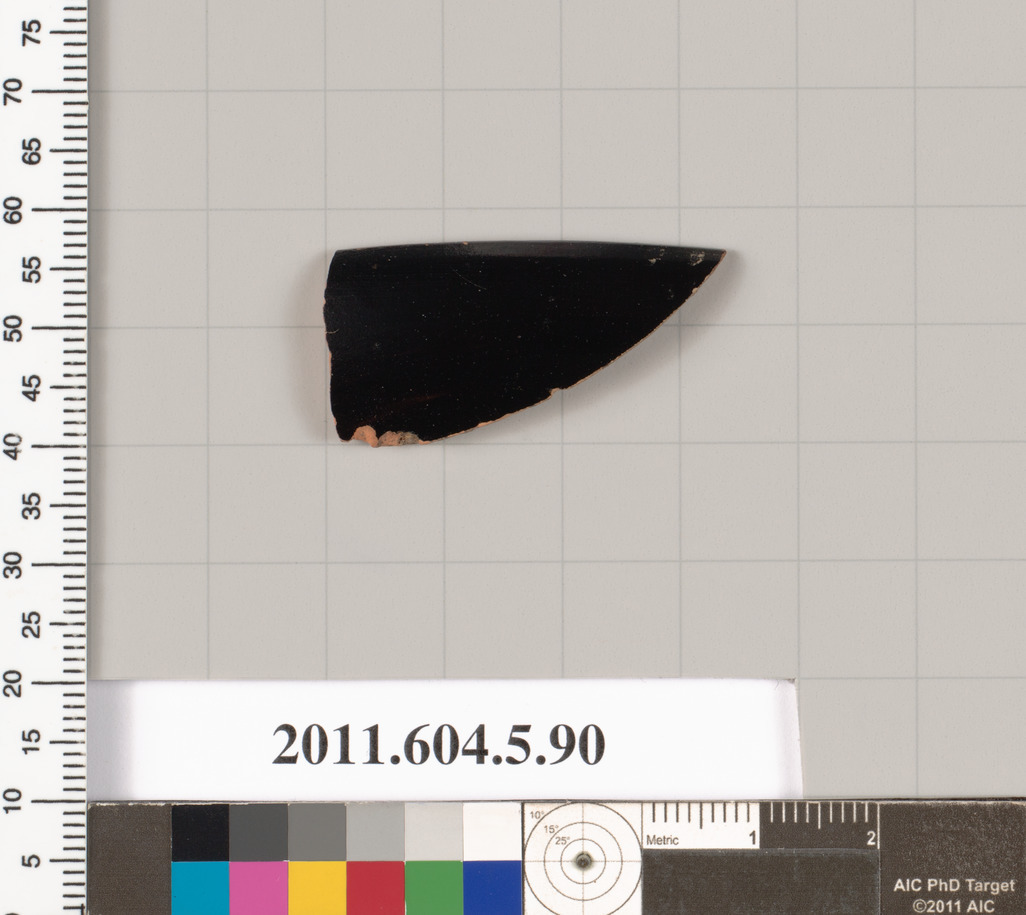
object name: kylix fragment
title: Terracotta rim fragment of a kylix (drinking cup)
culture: greek, attic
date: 500-480 BCE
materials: terracotta